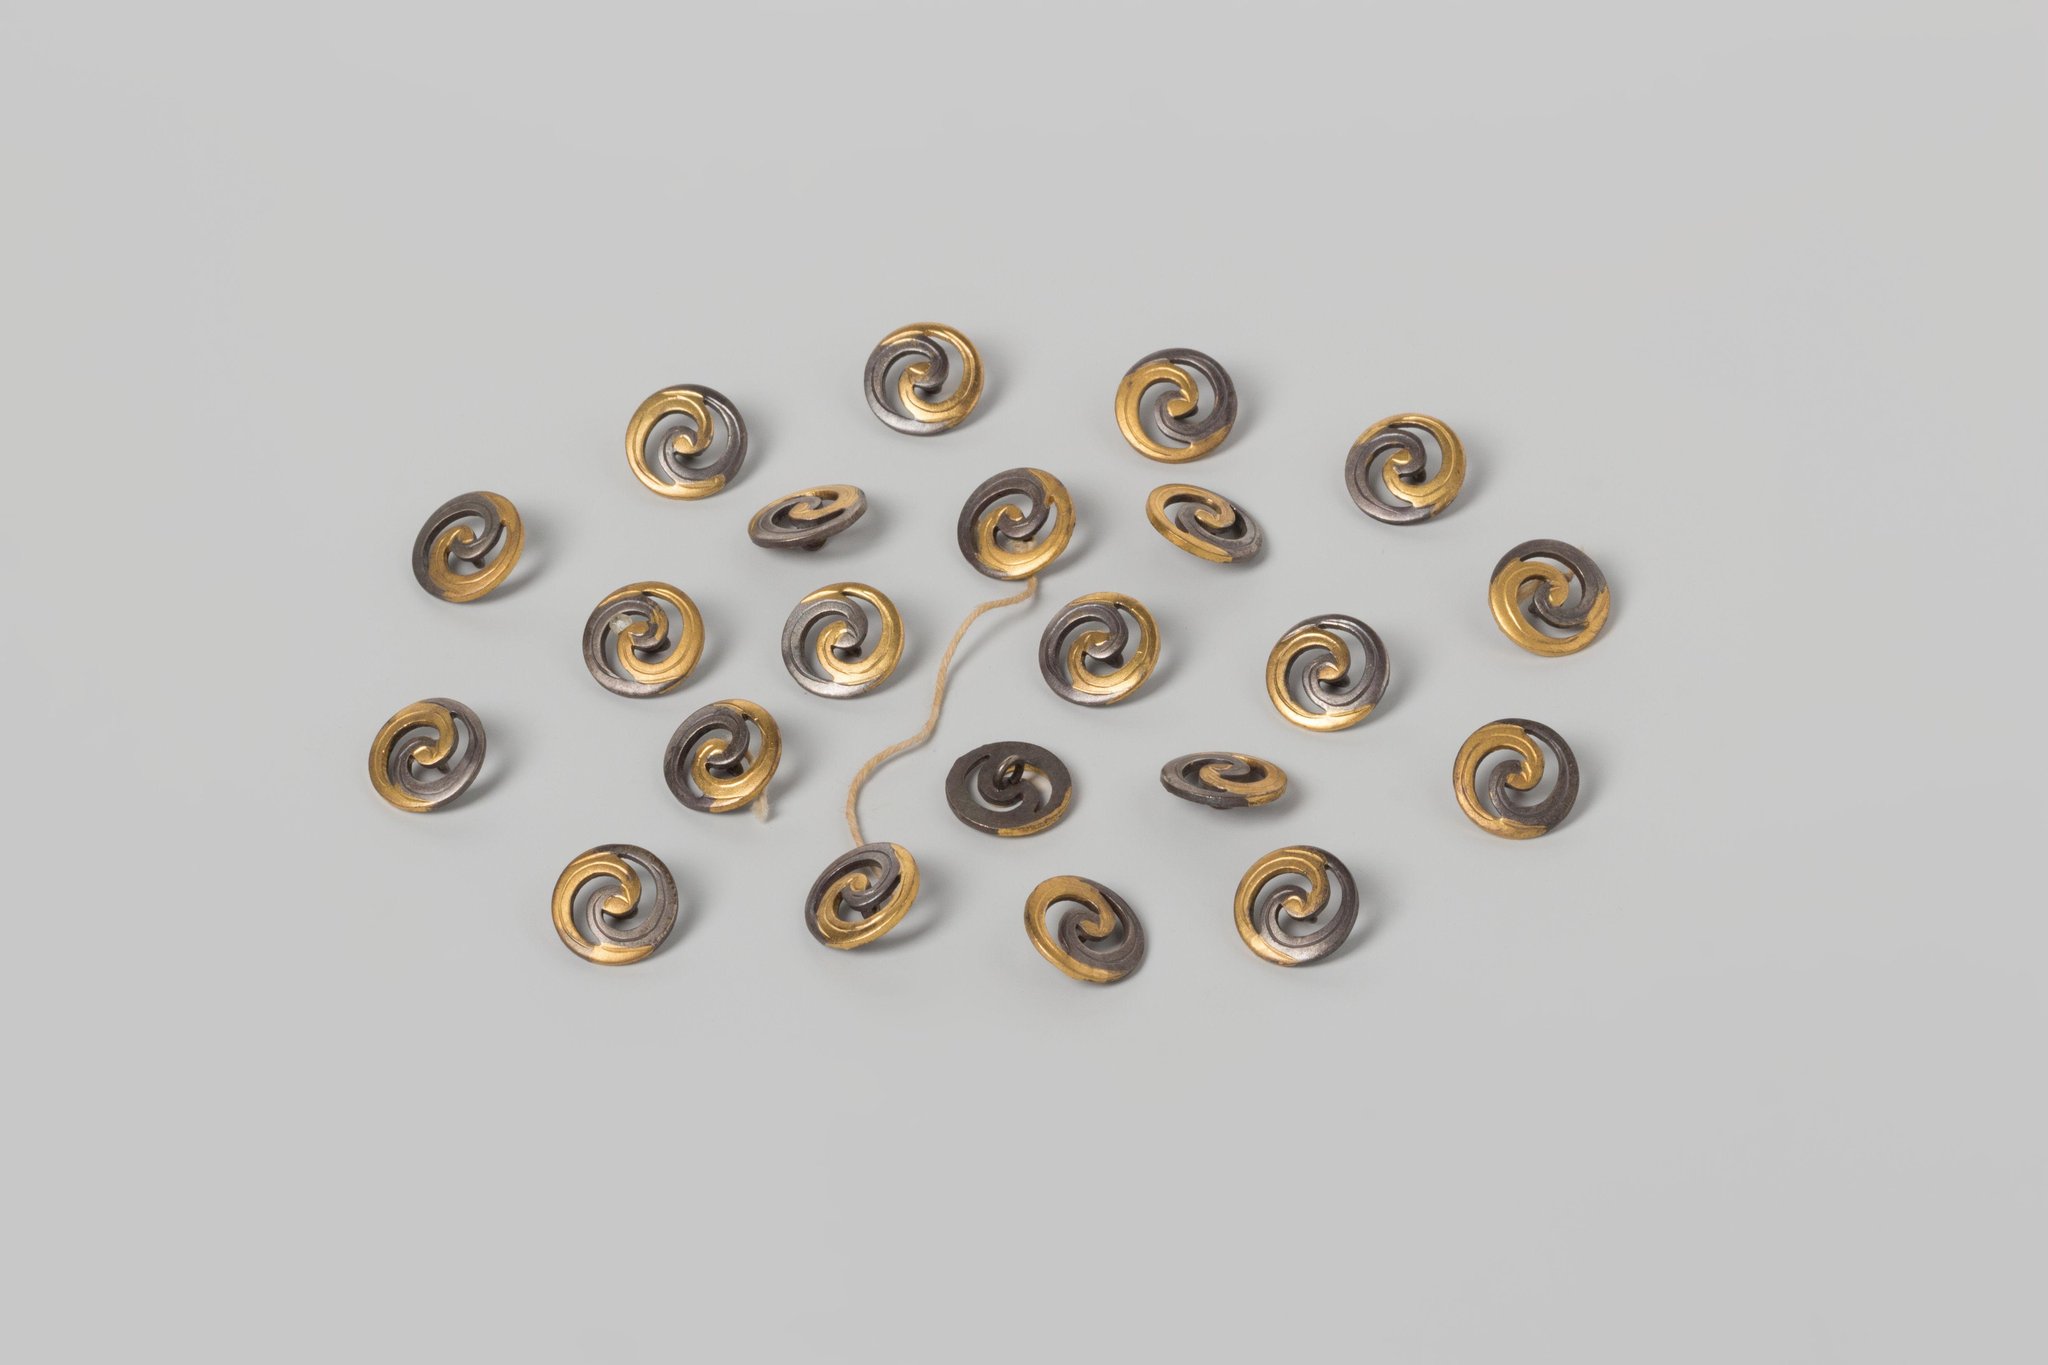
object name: clothing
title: Knoop, plat en rond, van gedeeltelijk met goudverf beschilderd metaal met krulmotief, gelijkend yin en yang, opengewerkt en gegraveerd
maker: Anonymous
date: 1880-1940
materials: paint, metal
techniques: embroidery, engraving, painting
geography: europe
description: Knoop, plat en rond, van gedeeltelijk met goudverf beschilderd metaal met krulmotief, gelijkend yin en yang, opengewerkt en gegraveerd.